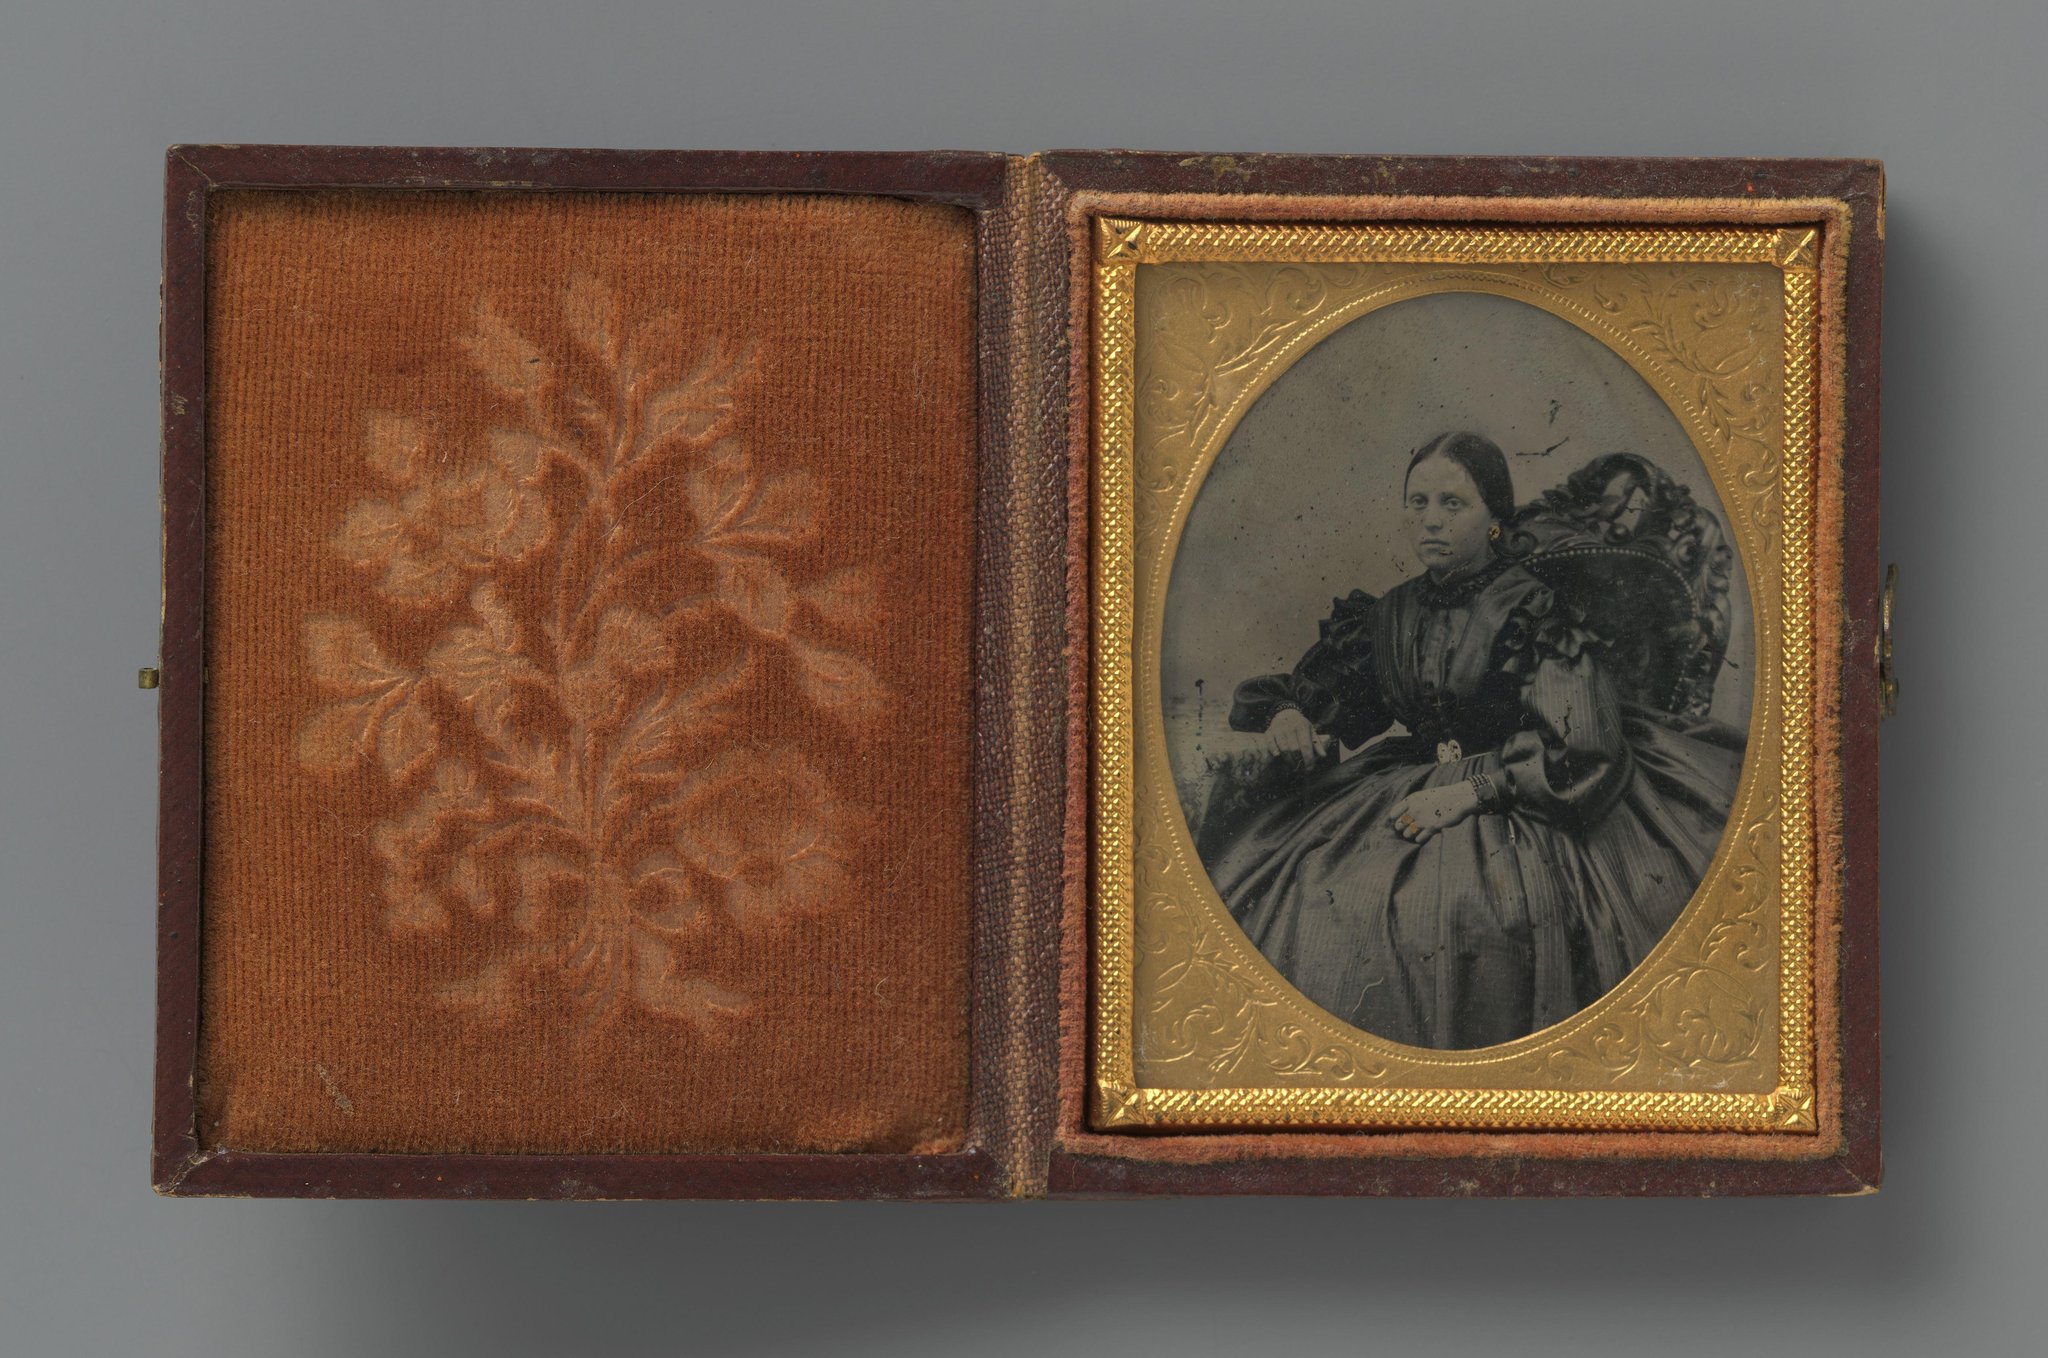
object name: photograph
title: Portret van Weduwe van Andel-van Schendel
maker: Anonymous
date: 1865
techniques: ambrotype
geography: haarlem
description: In etui samen met een portret van een onbekende Amerikaanse vrouw.